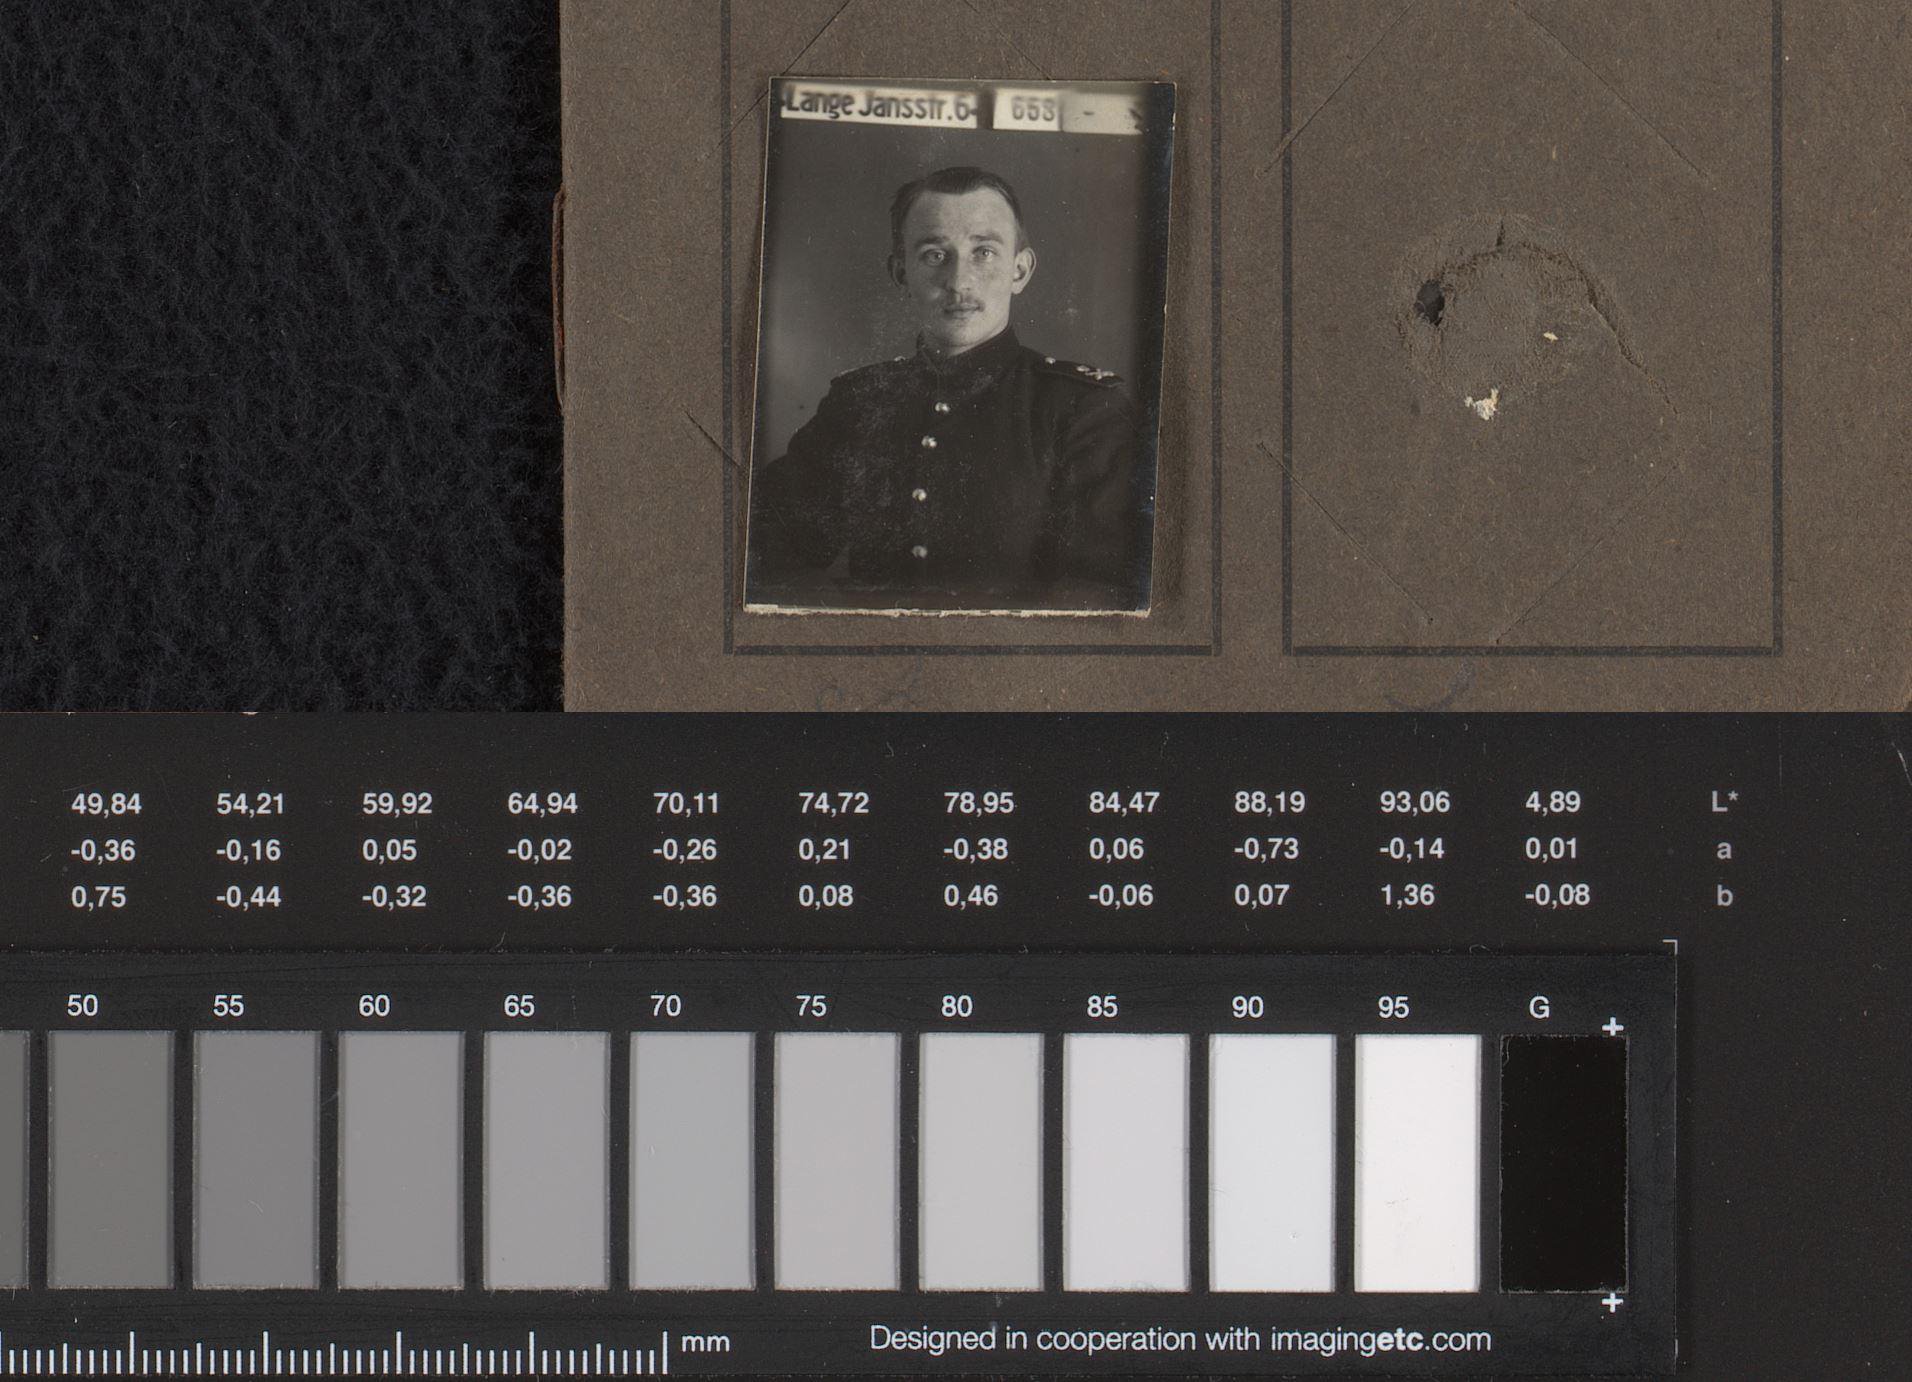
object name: album leaf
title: Portret van een onbekende man in militair uniform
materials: paper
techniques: gelatin silver print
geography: utrecht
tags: anonymous historical person portrayed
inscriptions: address: ‘Lange Jansstr. 6/ 653’